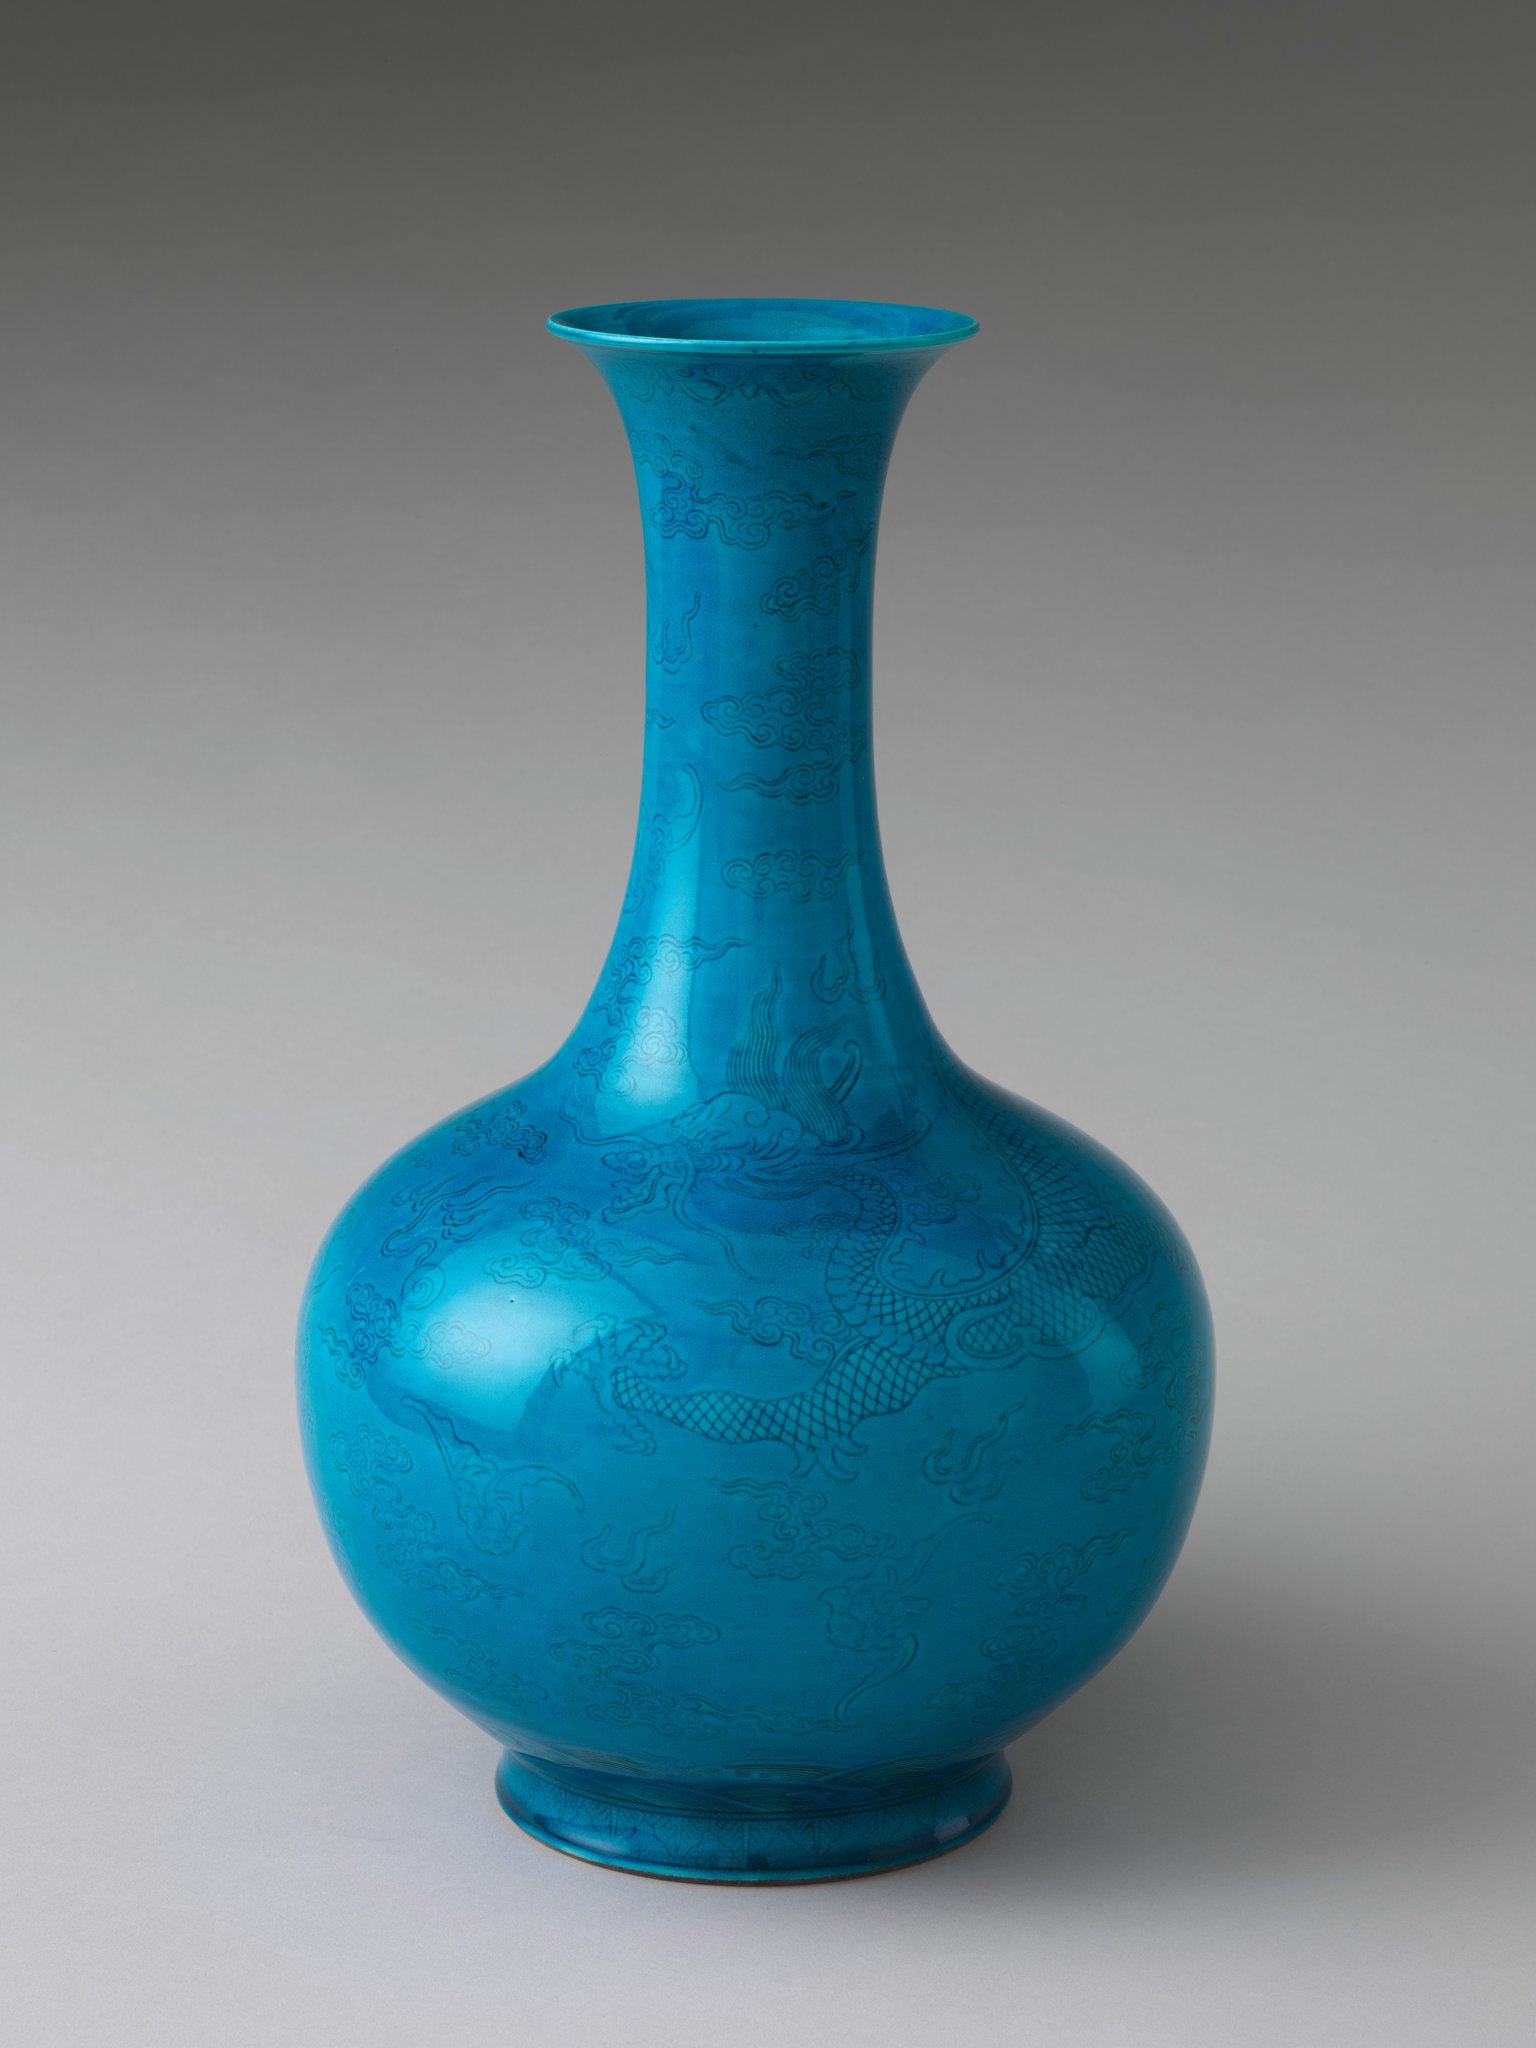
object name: vase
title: Vase with Dragons and Bats amid Clouds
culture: chinese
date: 1796-1820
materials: glaze, porcelain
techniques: incising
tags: bats,dragons,clouds